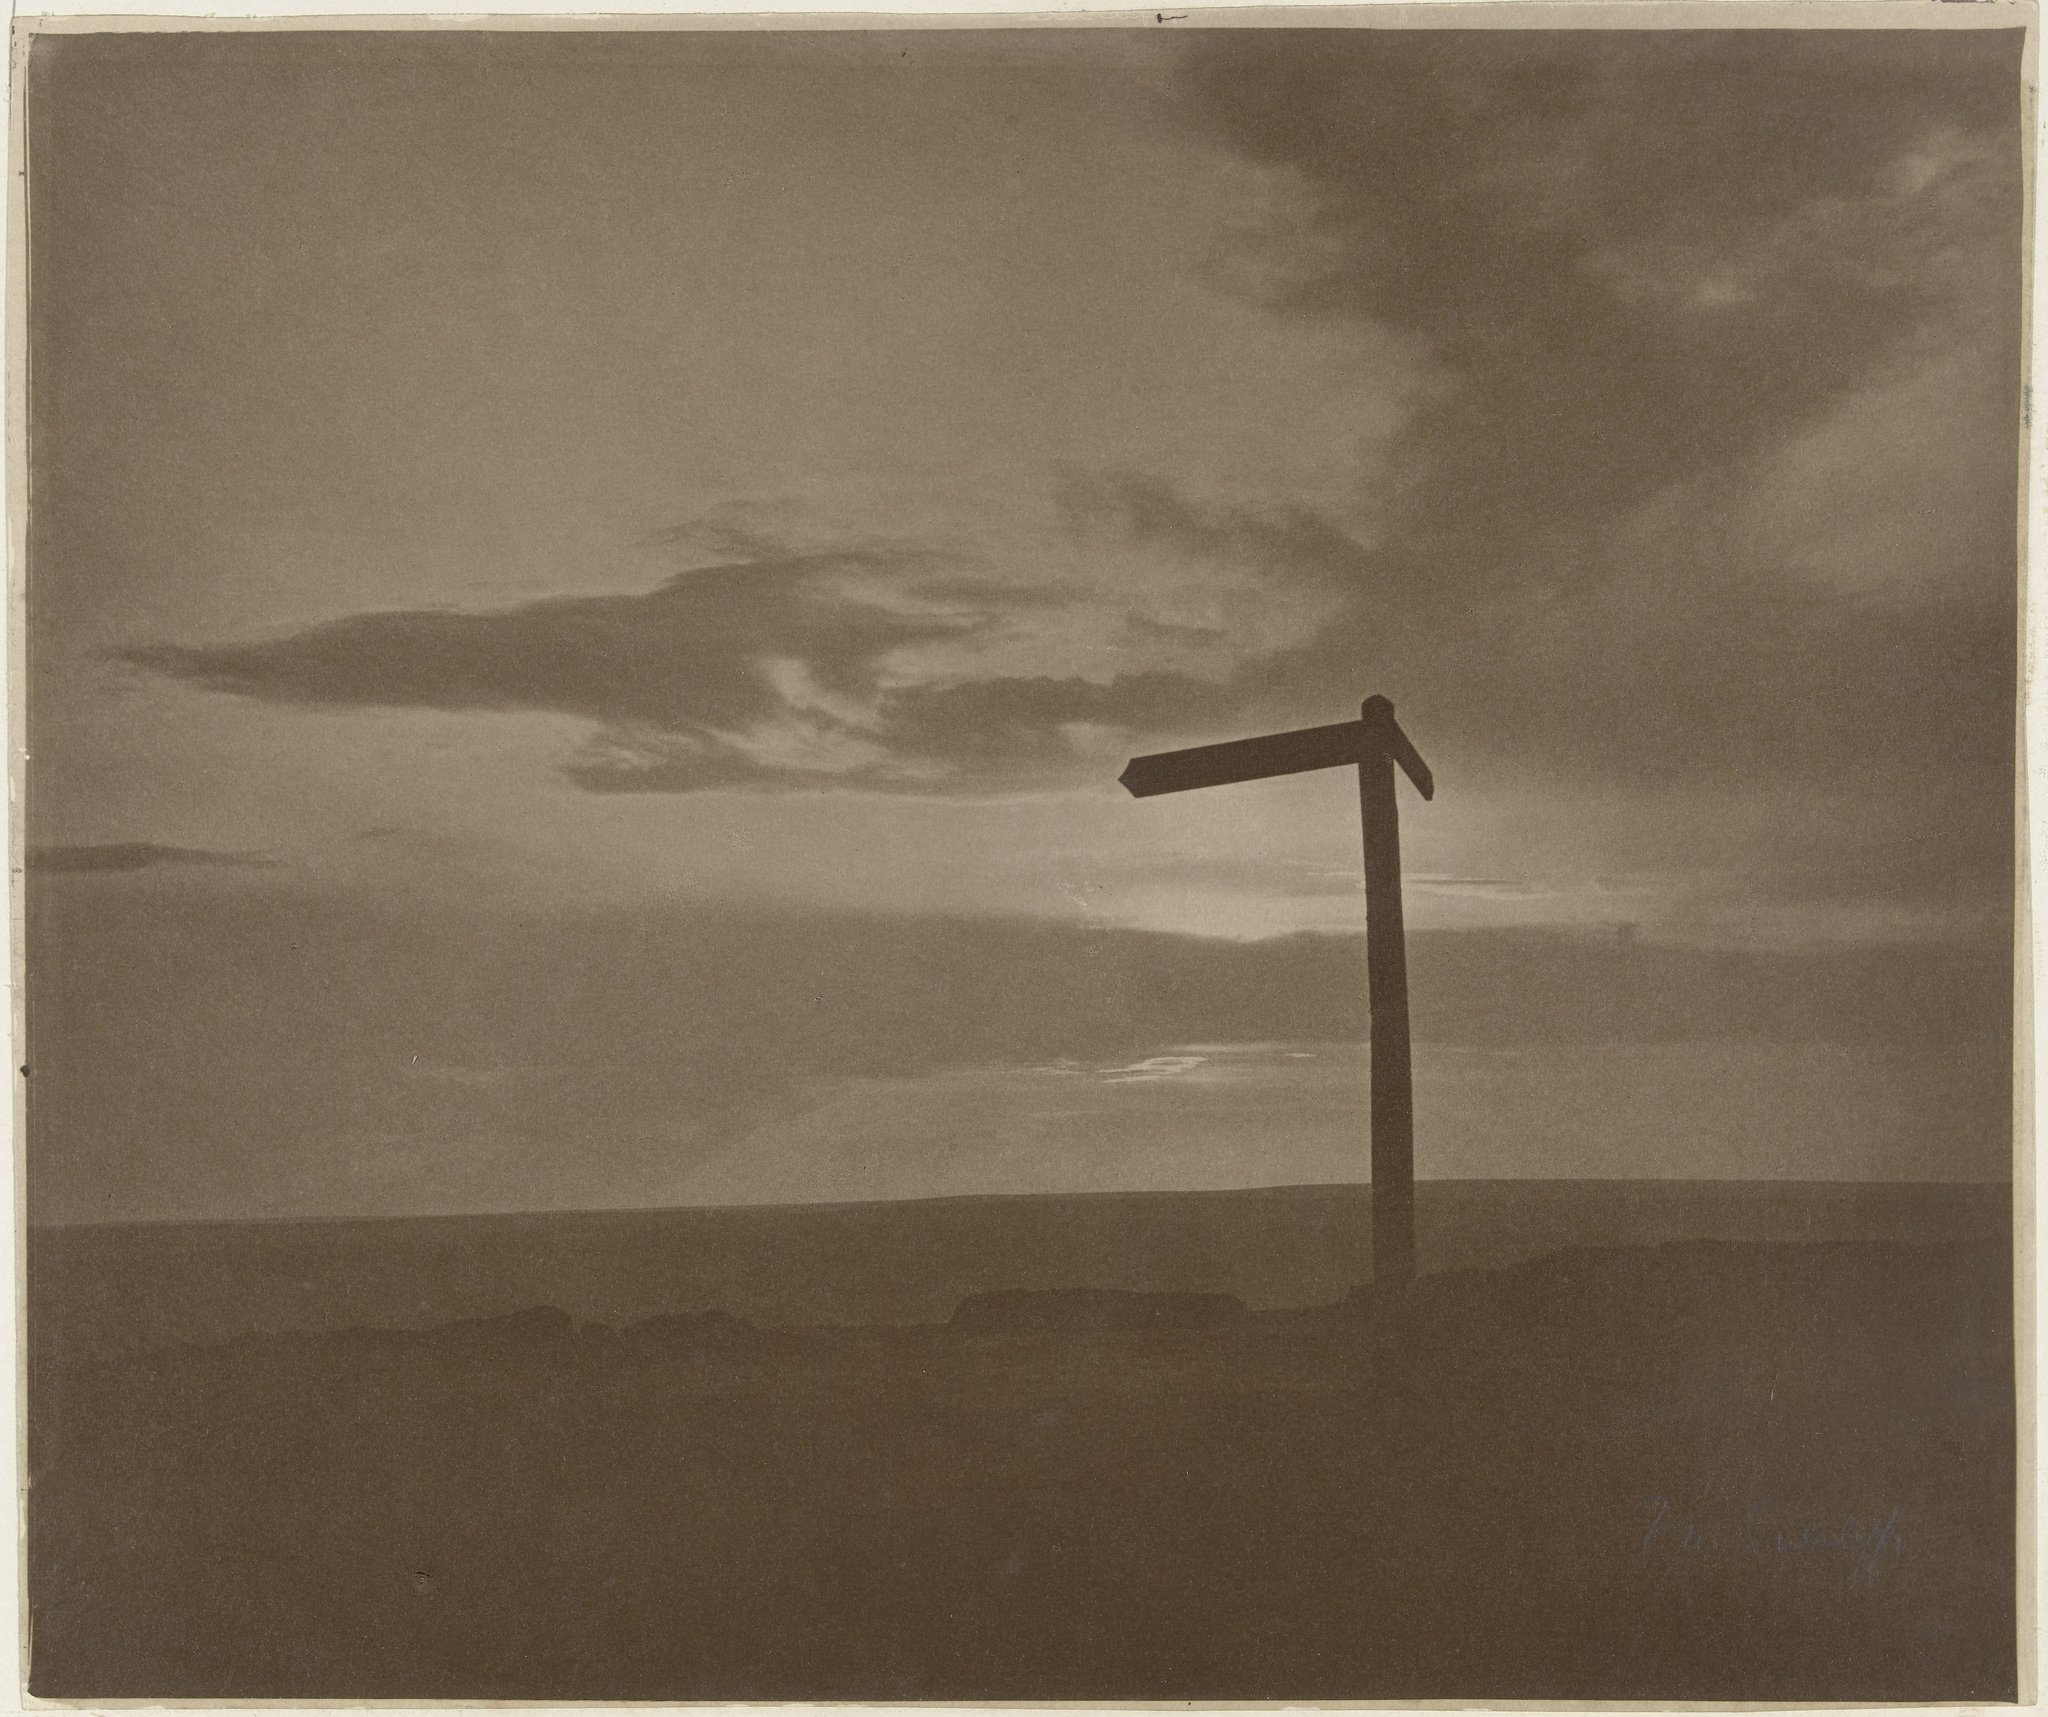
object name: photograph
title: Quo vadis?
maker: frank meadow sutcliffe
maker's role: fotograaf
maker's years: 1853-1941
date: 1871-1925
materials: cardboard, photographic support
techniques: carbon print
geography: great britain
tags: signpost, great britain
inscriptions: number: ‘63525/ A22’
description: Photographers wishing to lend their profession artistic standing could do so in various ways. Choosing subjects and poses derived from painting and sculpture was one option, soft focus was another. Sutcliffe gave this atmospheric landscape photograph a suggestive, symbolic title Quo vadis? (Where are you going?). It doubtless refers to the then popular novel Henryk Sienkiewicz published in 1895.